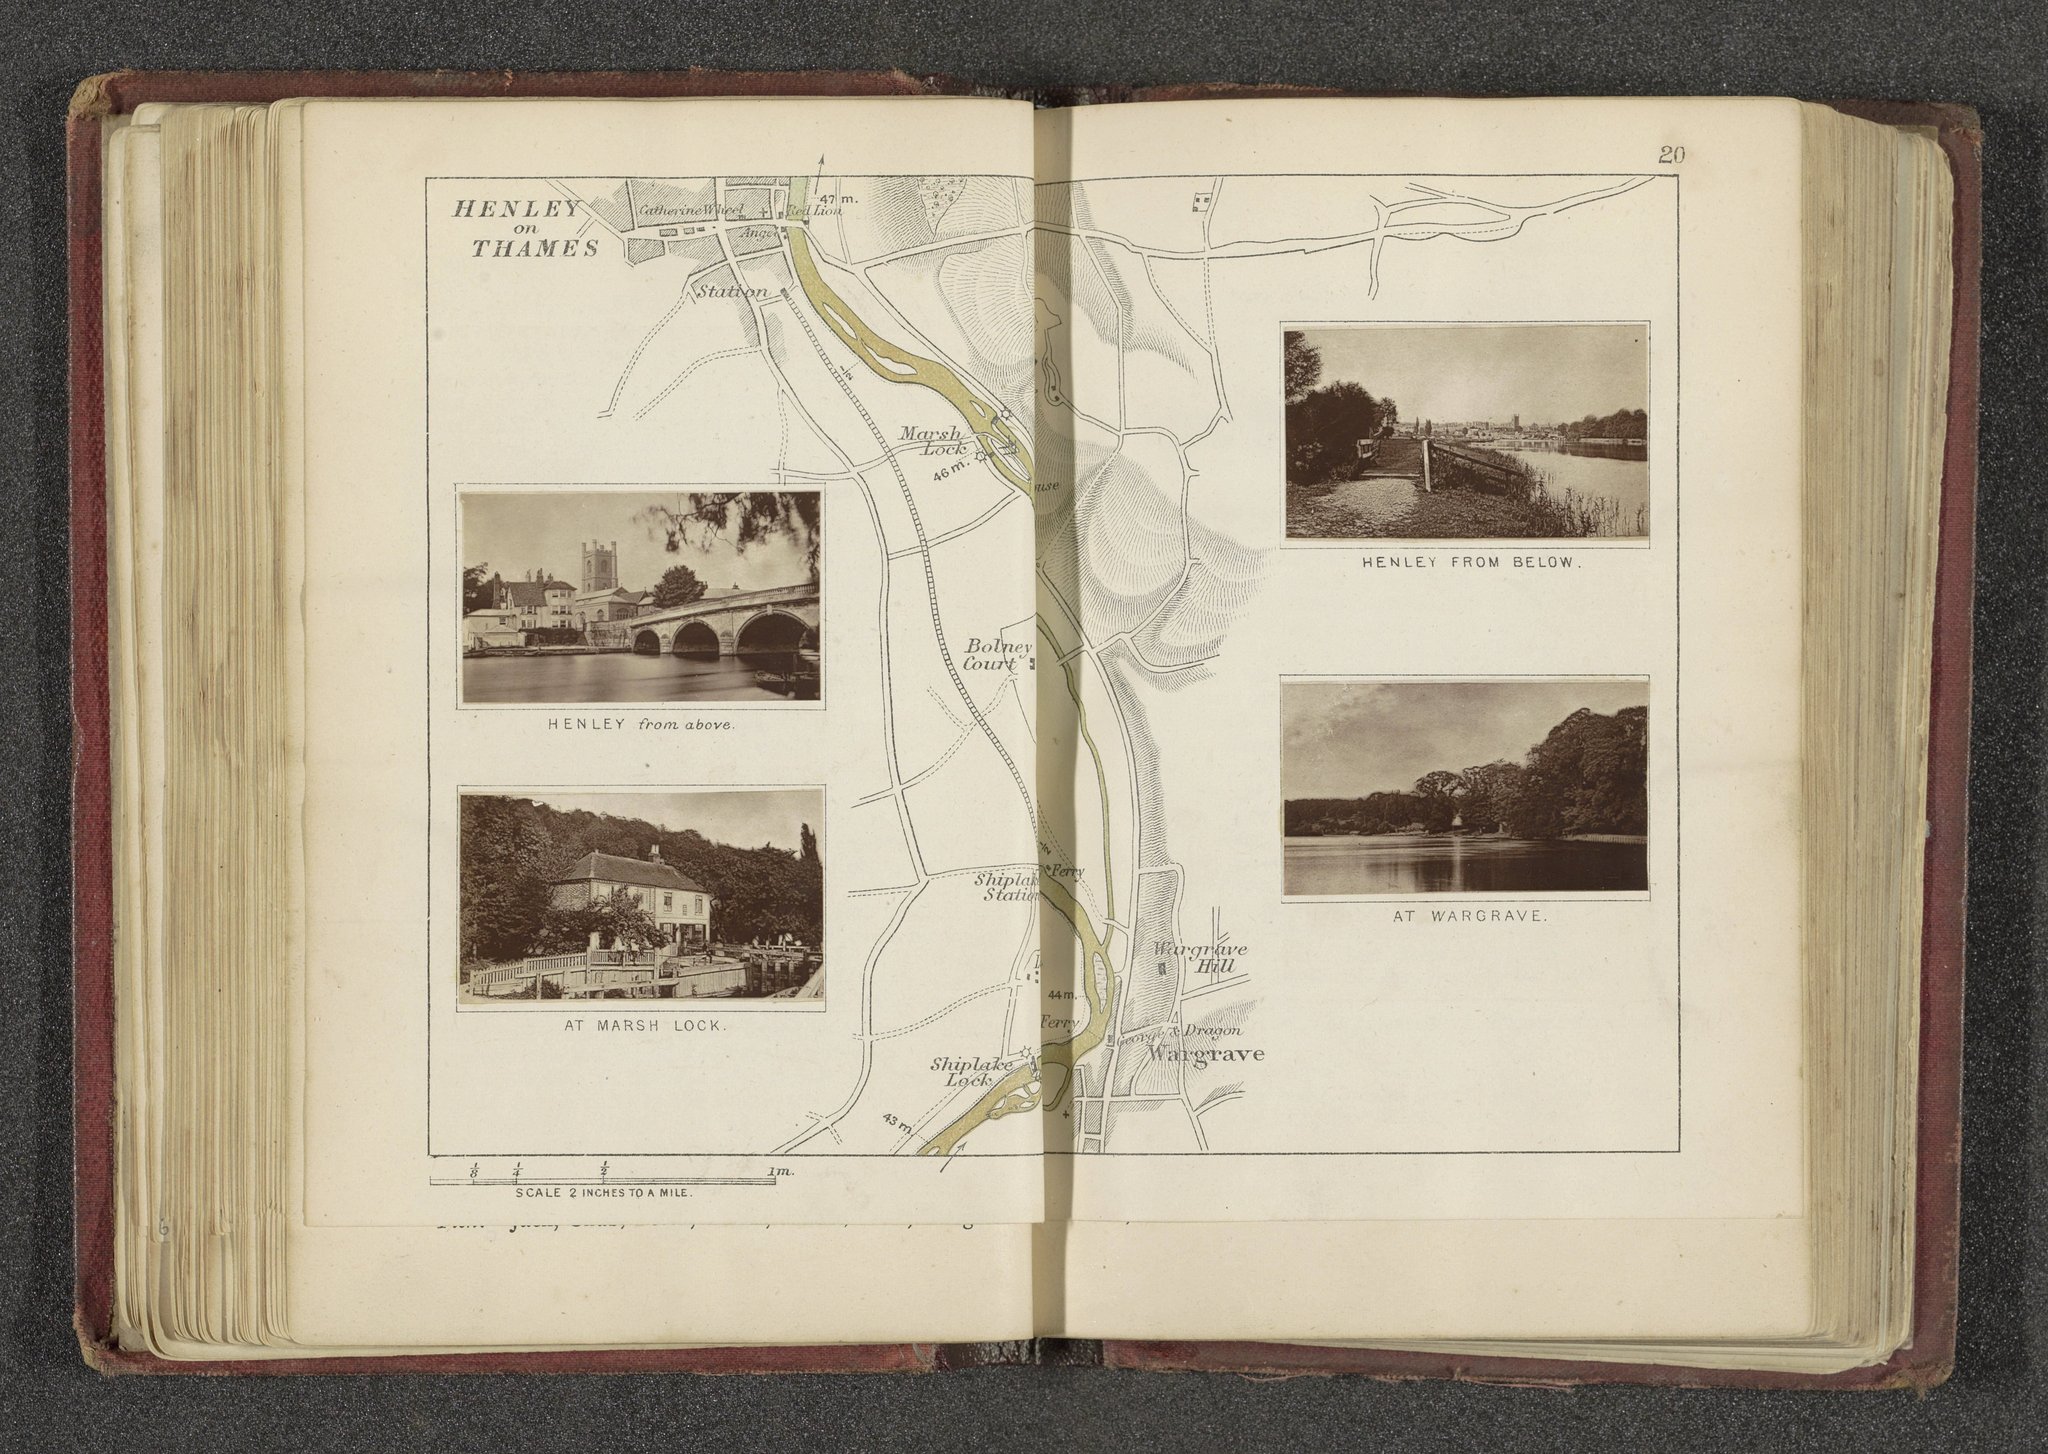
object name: print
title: Kaart met vier afbeeldingen van plaatsen langs de Theems bij Henley-on-Thames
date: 1878-1879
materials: paper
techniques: engraving, woodburytype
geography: henley-on-thames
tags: sluice, weir, city-view, and landscape with man-made constructions, river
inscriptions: number: ‘20’, inscription: ‘Henley from above. At marsh lock. Heney from below. At wargrave.’